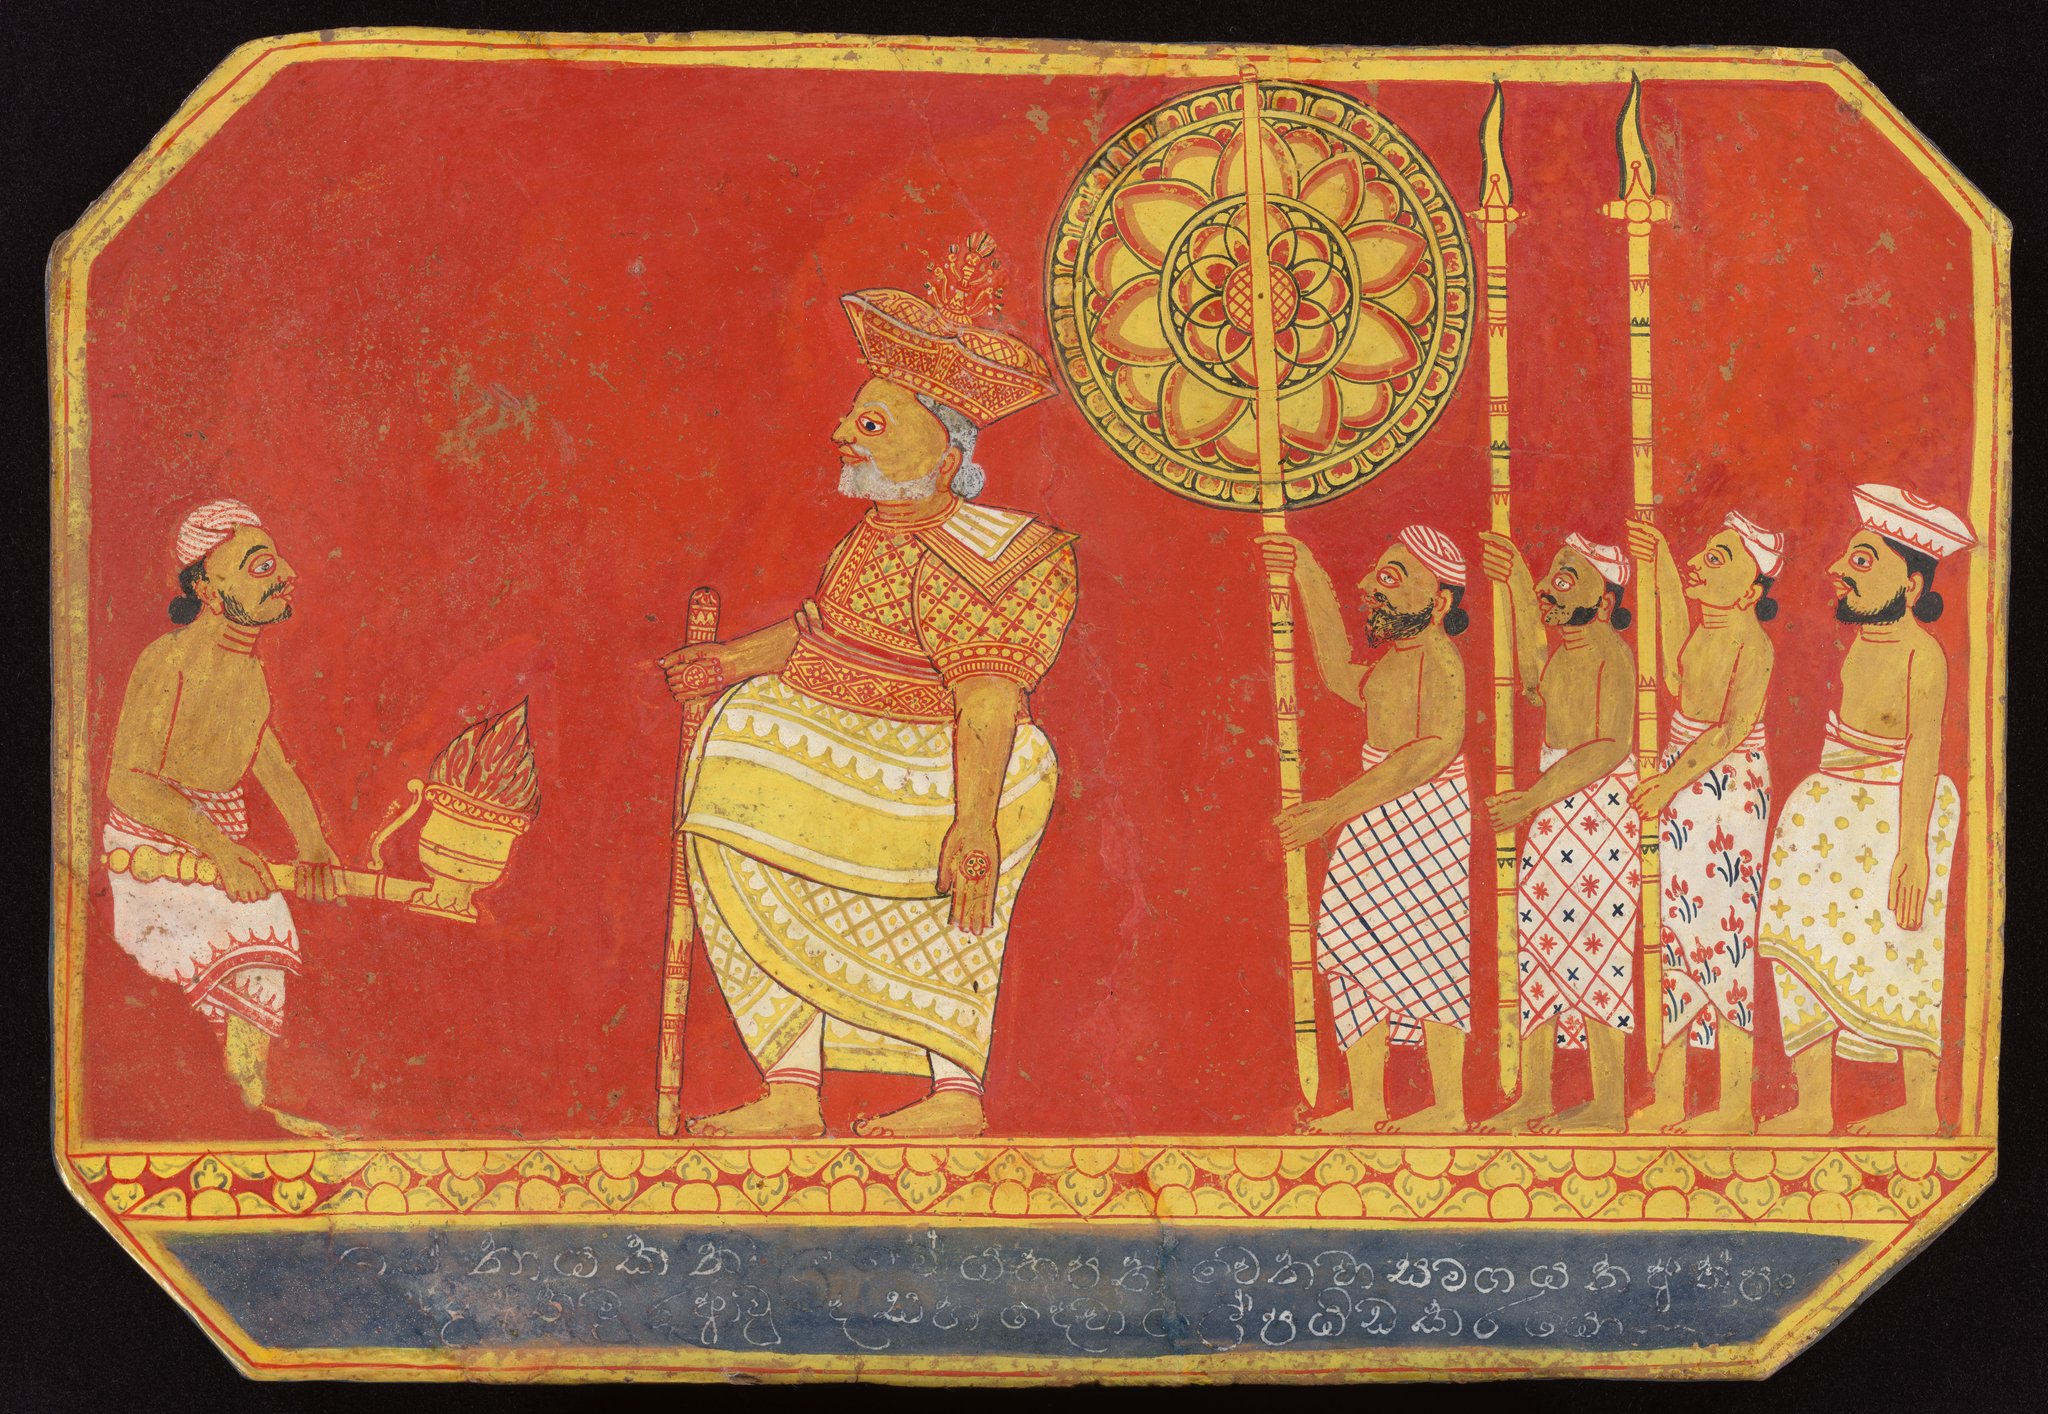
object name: tile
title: Kandyan chief processing to a temple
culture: sri lanka, kandy district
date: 1851-1900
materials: terracotta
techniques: painting